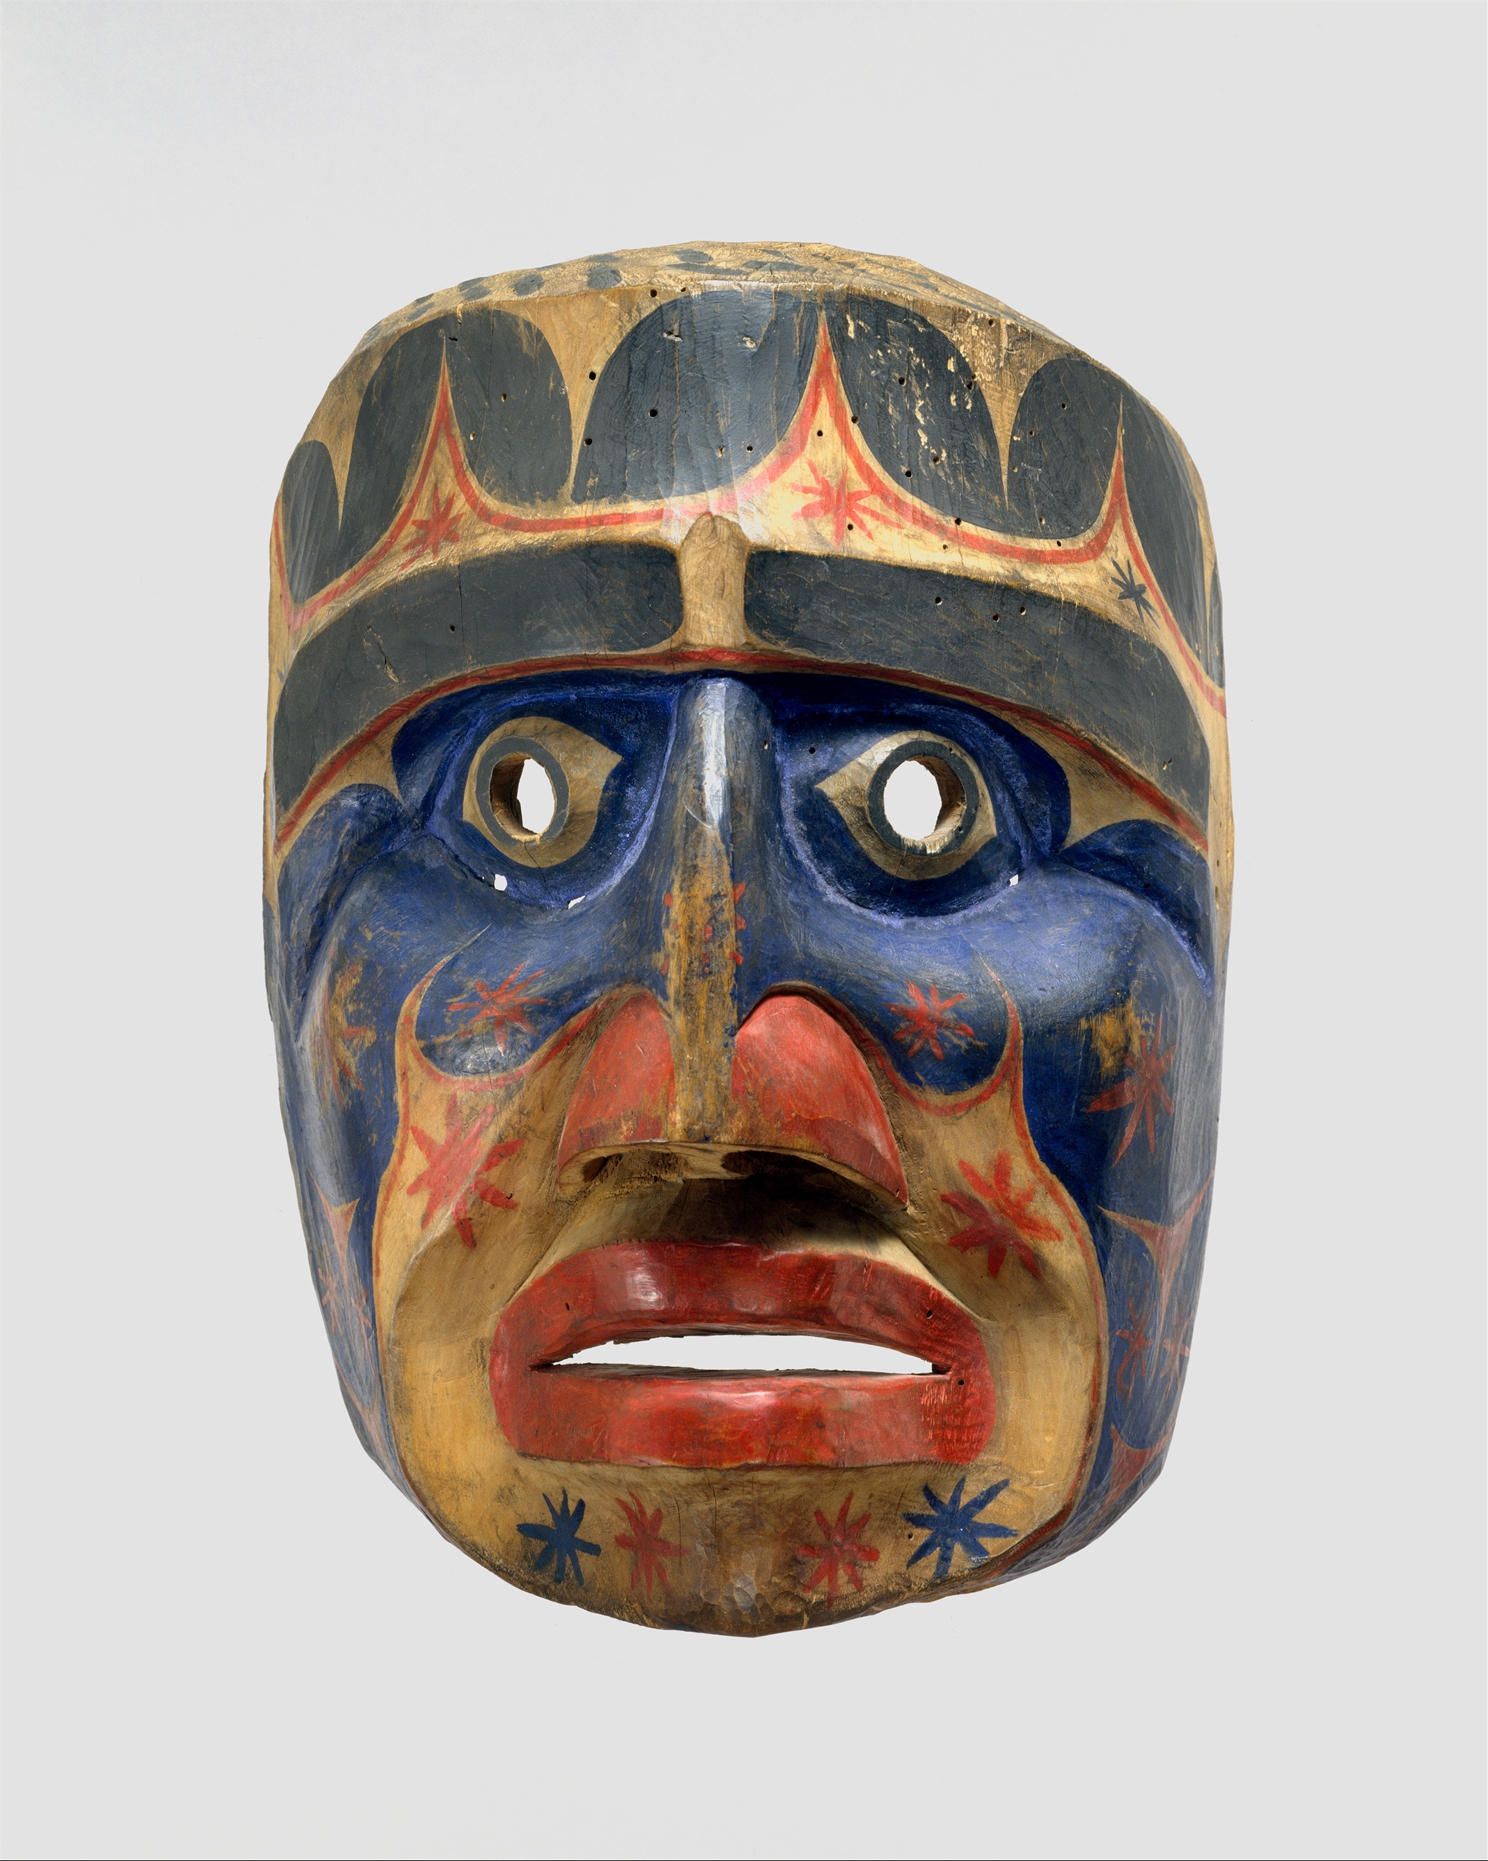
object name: mask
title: Komokwa Mask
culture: kwakwaka'wakw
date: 1880-1890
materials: pigment, wood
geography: canada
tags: faces